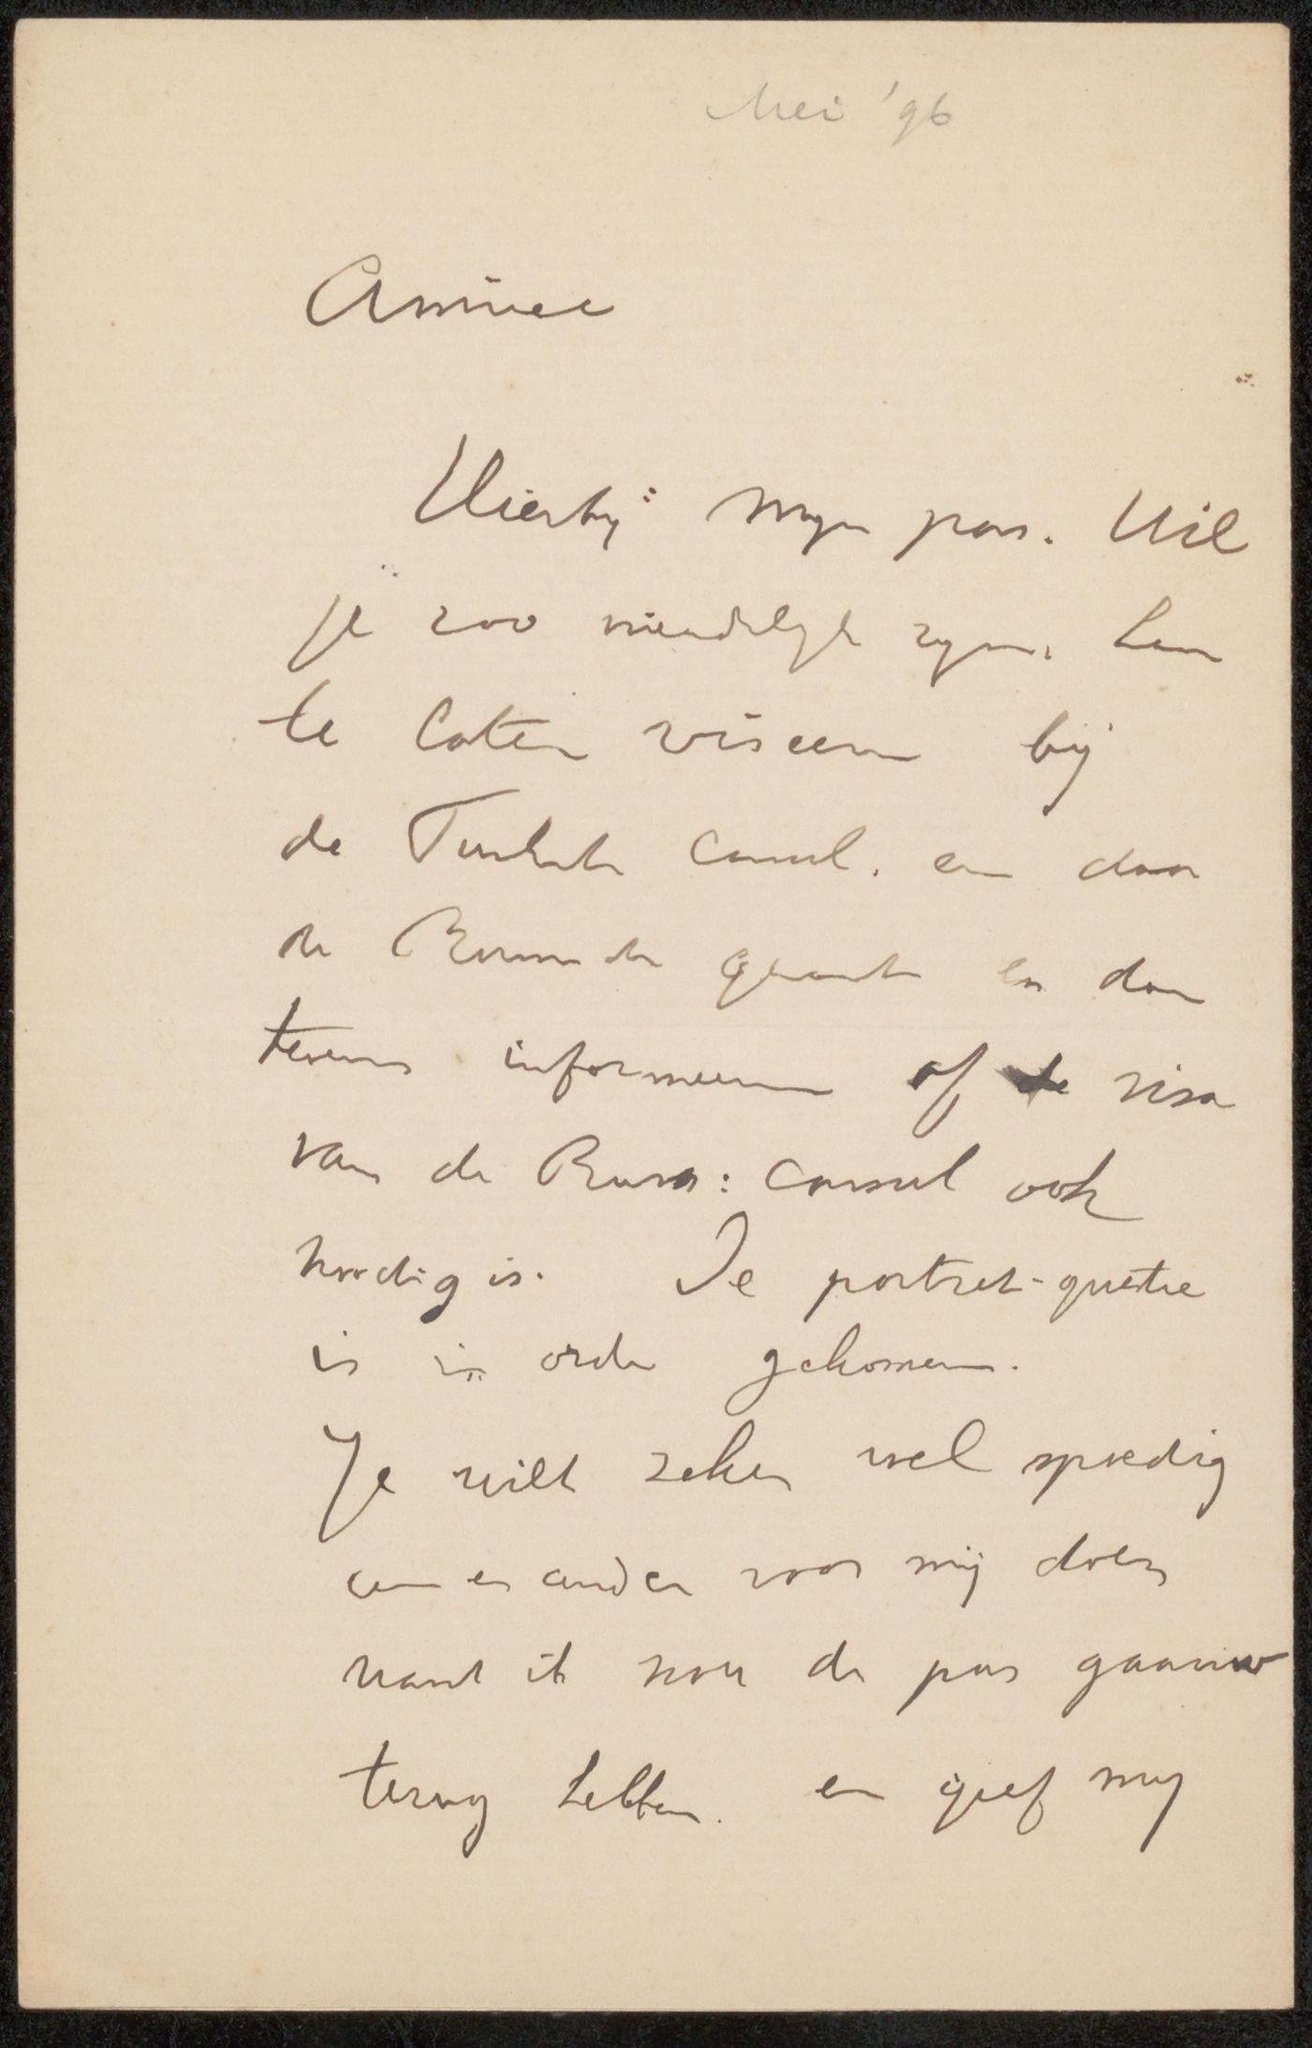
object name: letter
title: Brief aan Philip Zilcken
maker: marius bauer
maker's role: draughtsman, print maker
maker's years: 1867-1932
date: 1877-1932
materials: ink, paper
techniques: pen, writing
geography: bussum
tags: the hague, painter, philip zilcken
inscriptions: collector's mark: ‘RPK’